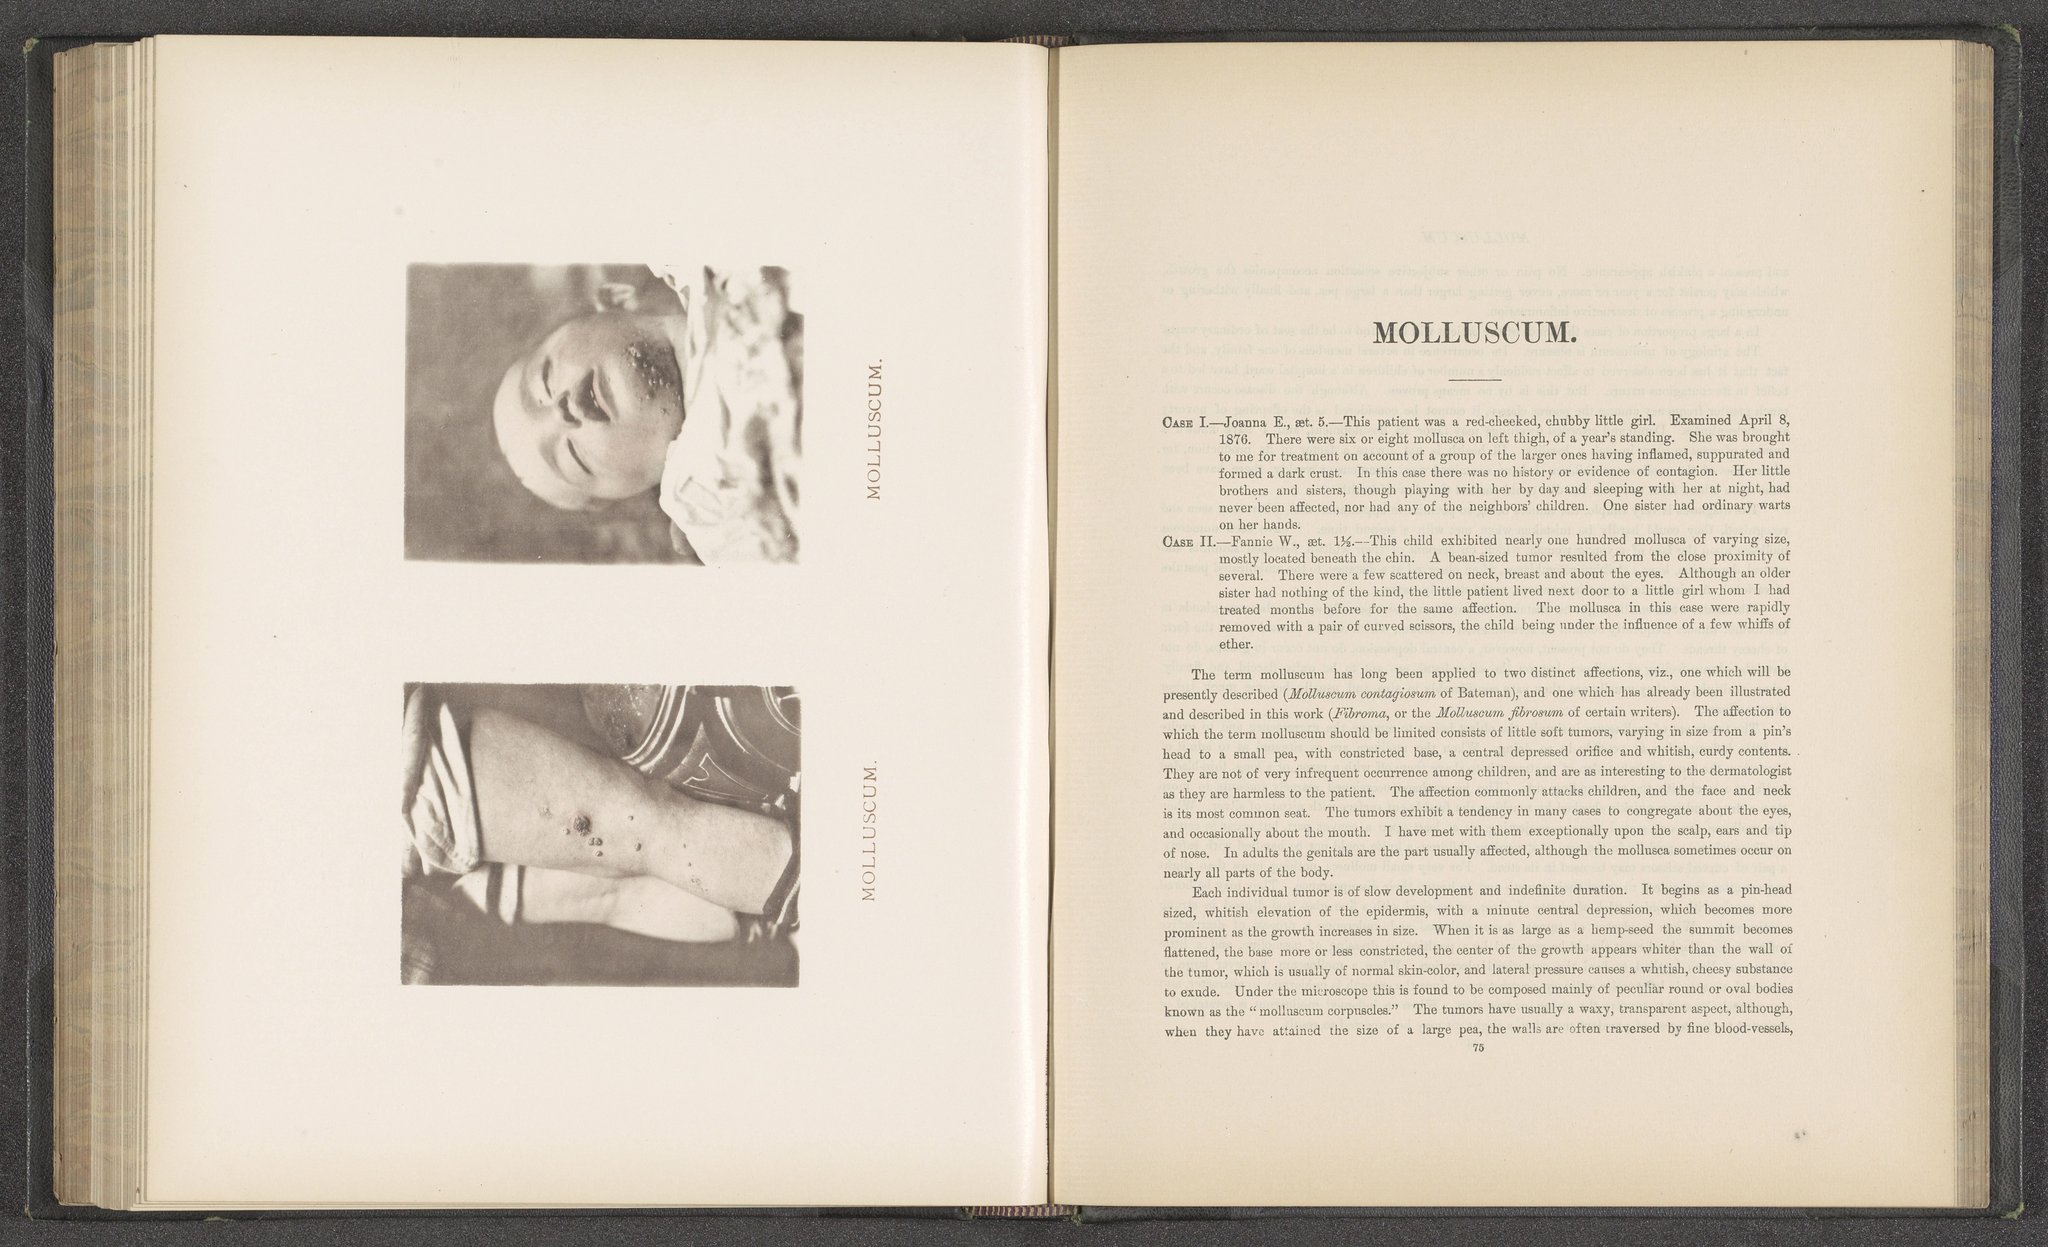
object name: page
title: Patiënten lijdend aan de huidziekte 'molluscum'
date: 1870-1881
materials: paper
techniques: photograph, hand coloring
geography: new york city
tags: face, skin and venereal diseases, child, legs